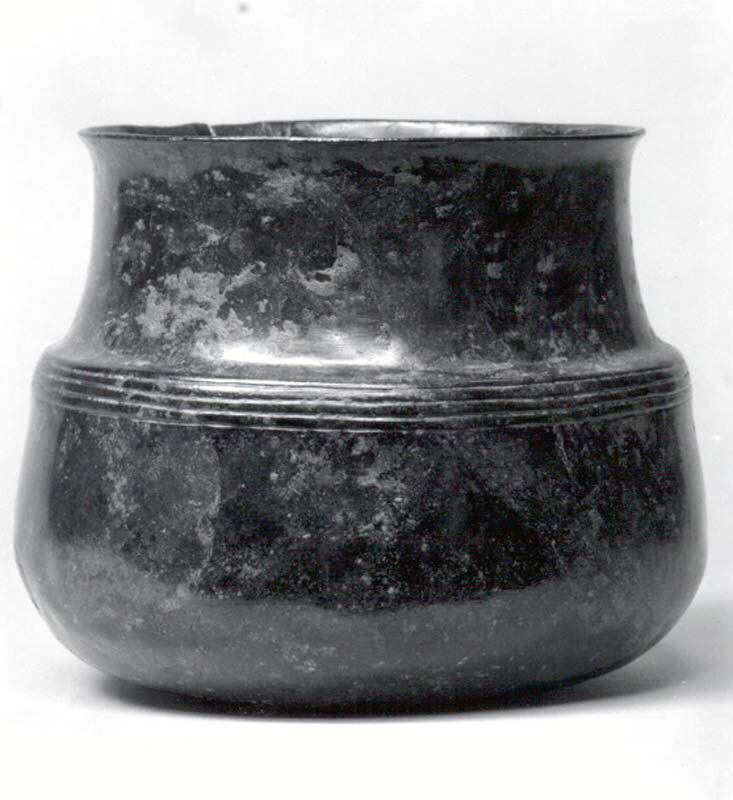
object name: jar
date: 1000-750 BCE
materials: bronze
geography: iran